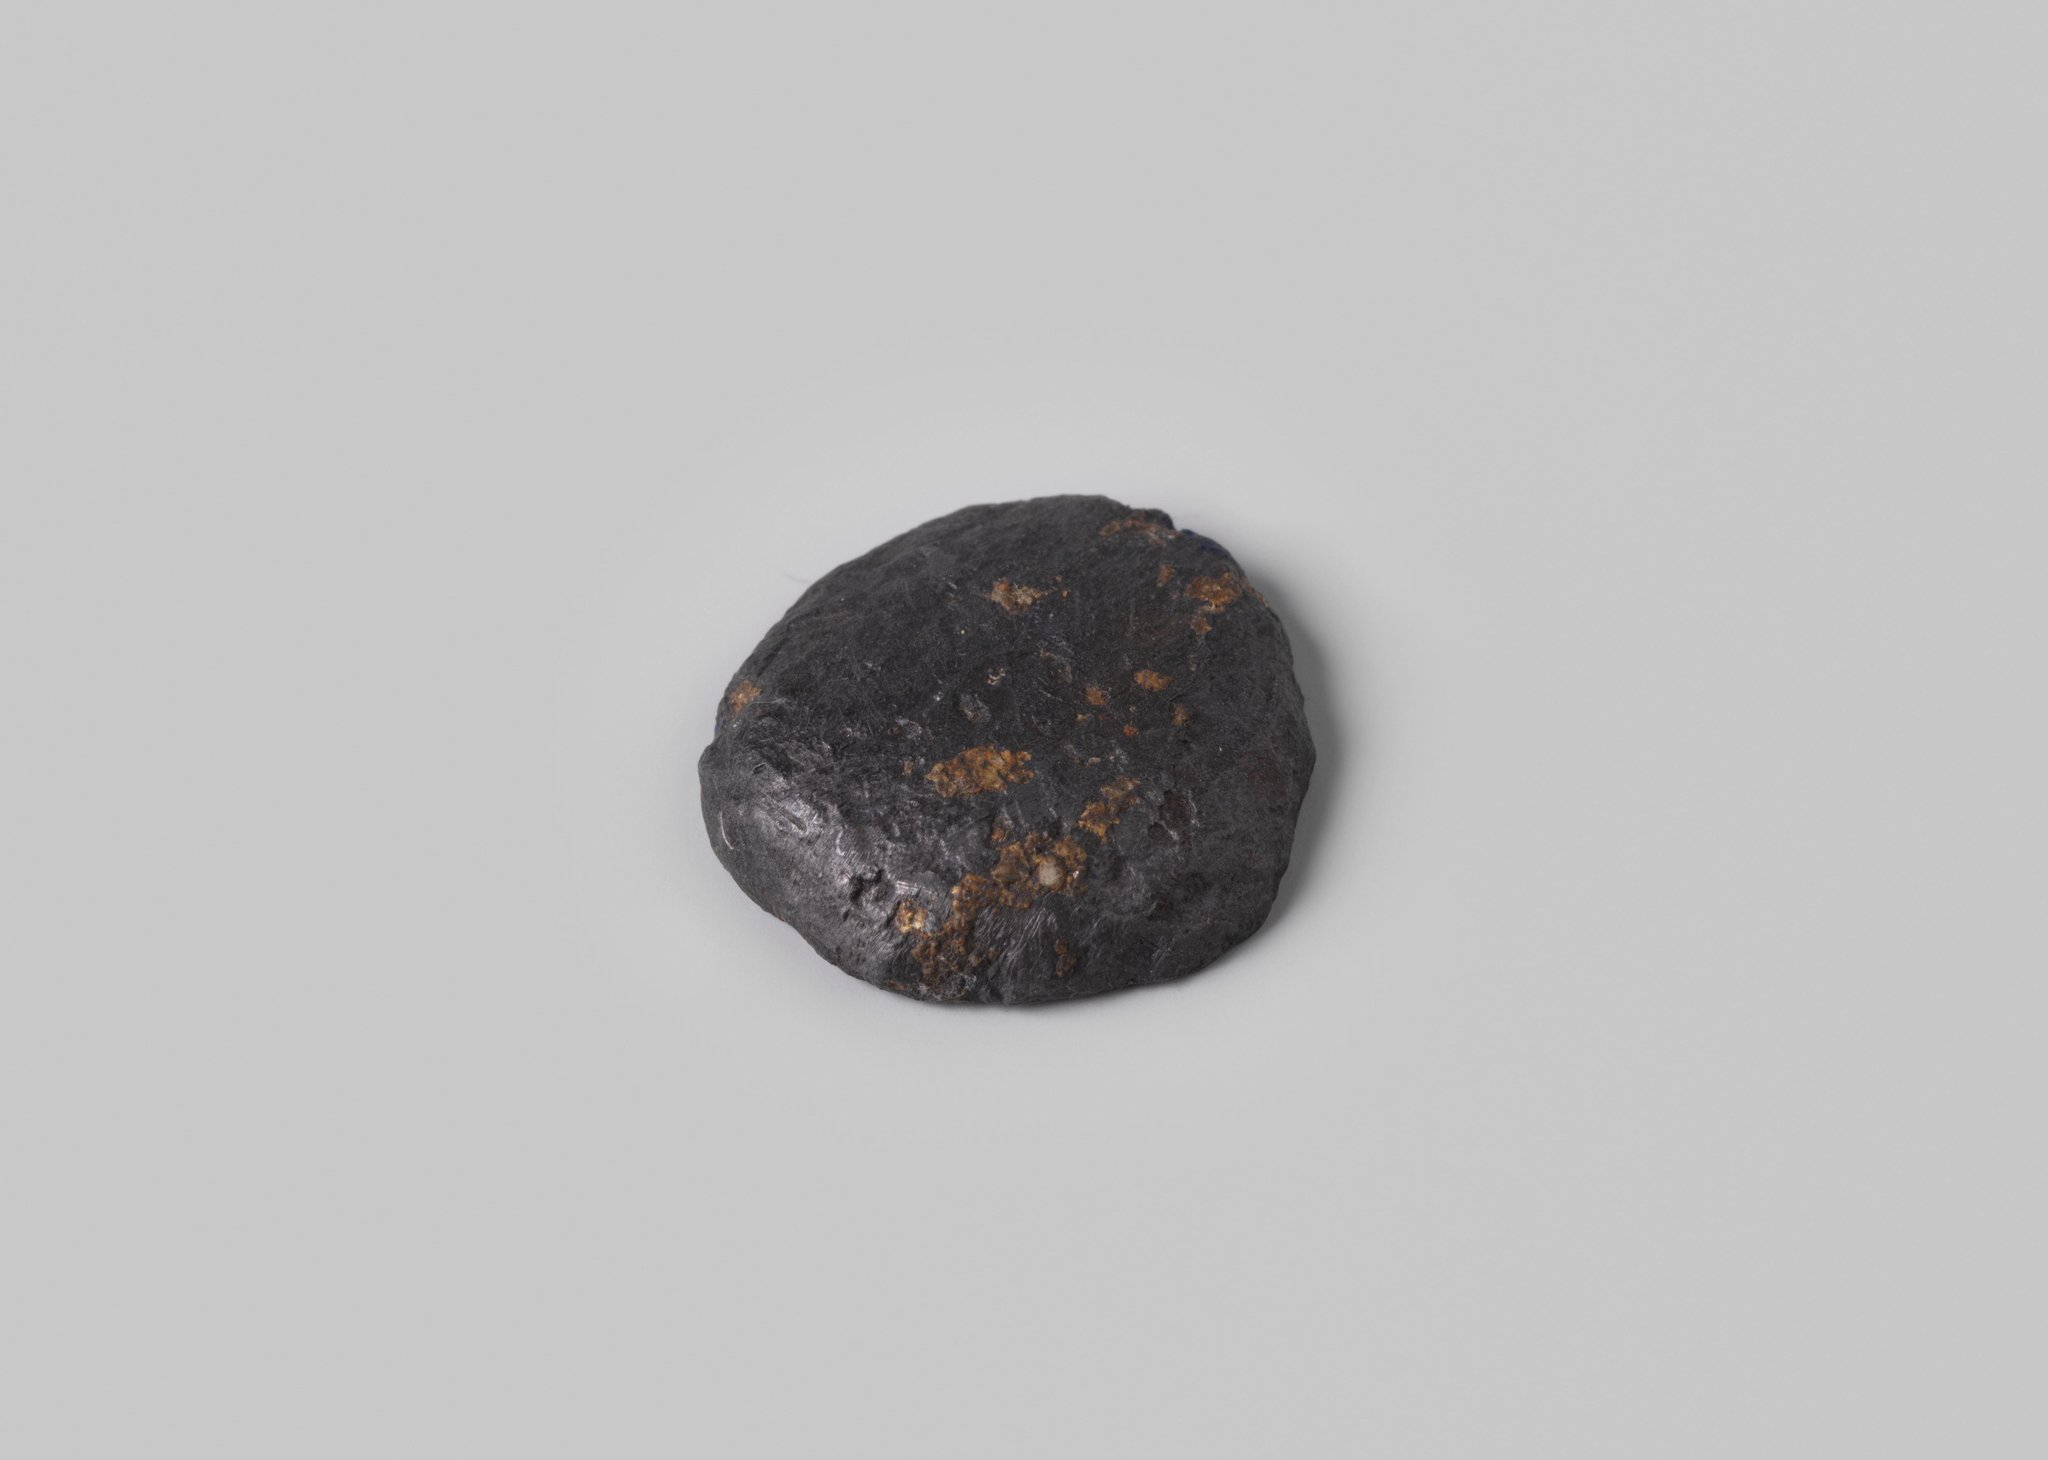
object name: weight scale component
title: Disc shaped weight, lead, from the wreck of the Dutch East India ship Hollandia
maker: Anonymous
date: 1700-1743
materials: lead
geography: netherlands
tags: verenigde oostindische compagnie, hollandia (schip), annet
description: Disc-shaped weight, circular, slightly convex top, concave underside.